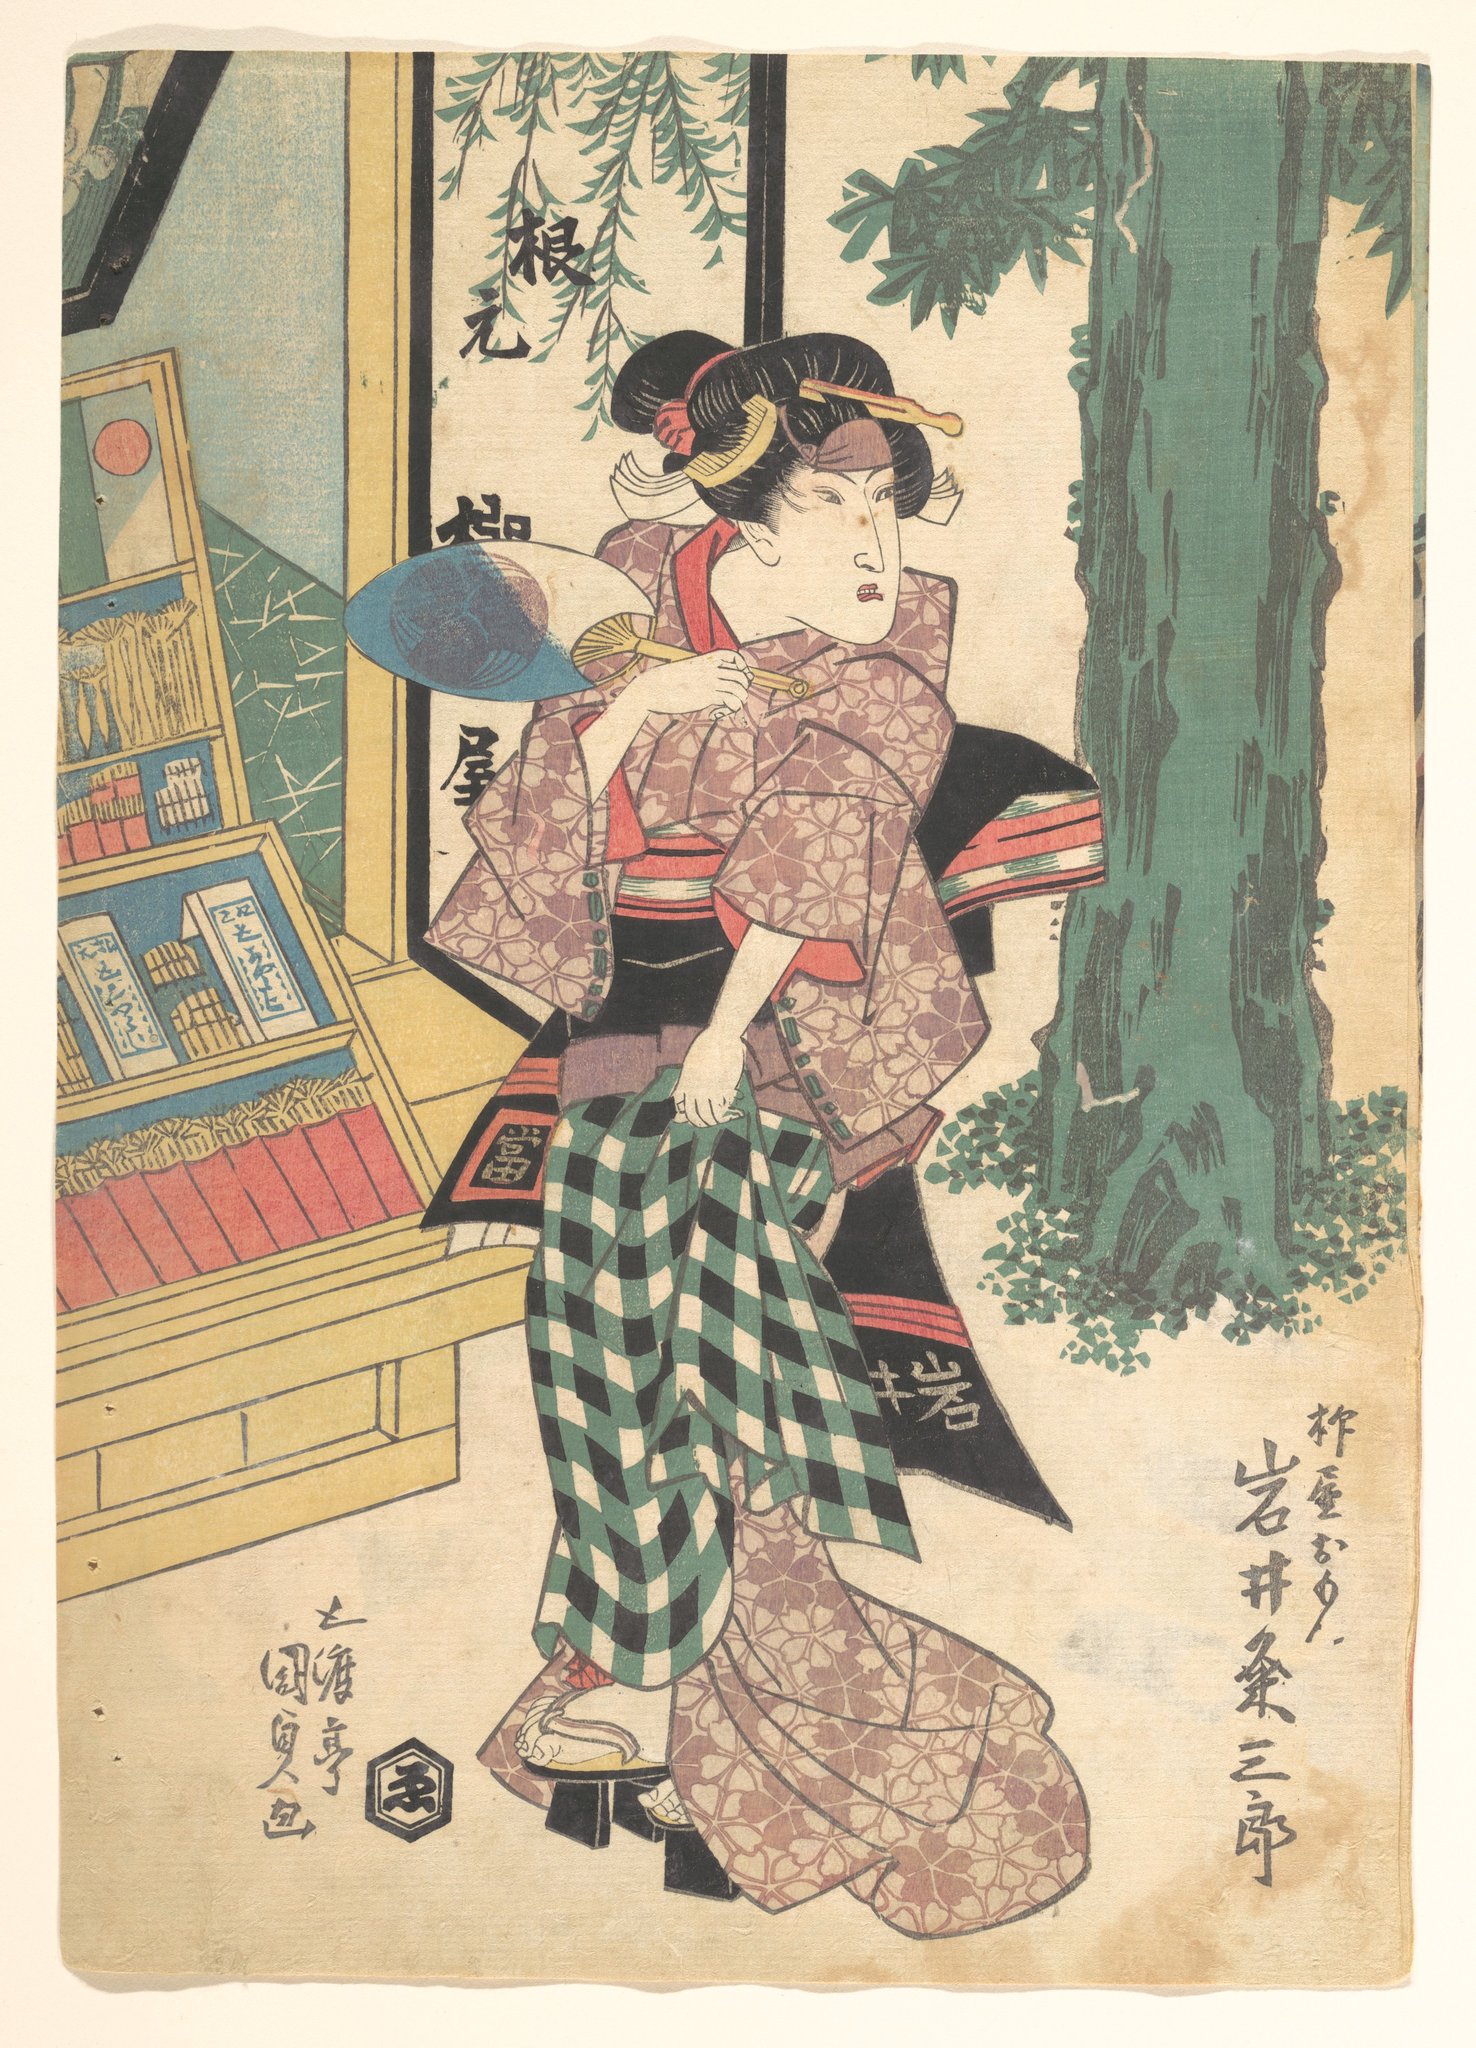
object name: print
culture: japanese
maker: utagawa kunisada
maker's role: artist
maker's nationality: japanese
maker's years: 1786-1864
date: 1801-1900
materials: ink, paper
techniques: woodblock print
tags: fans,women